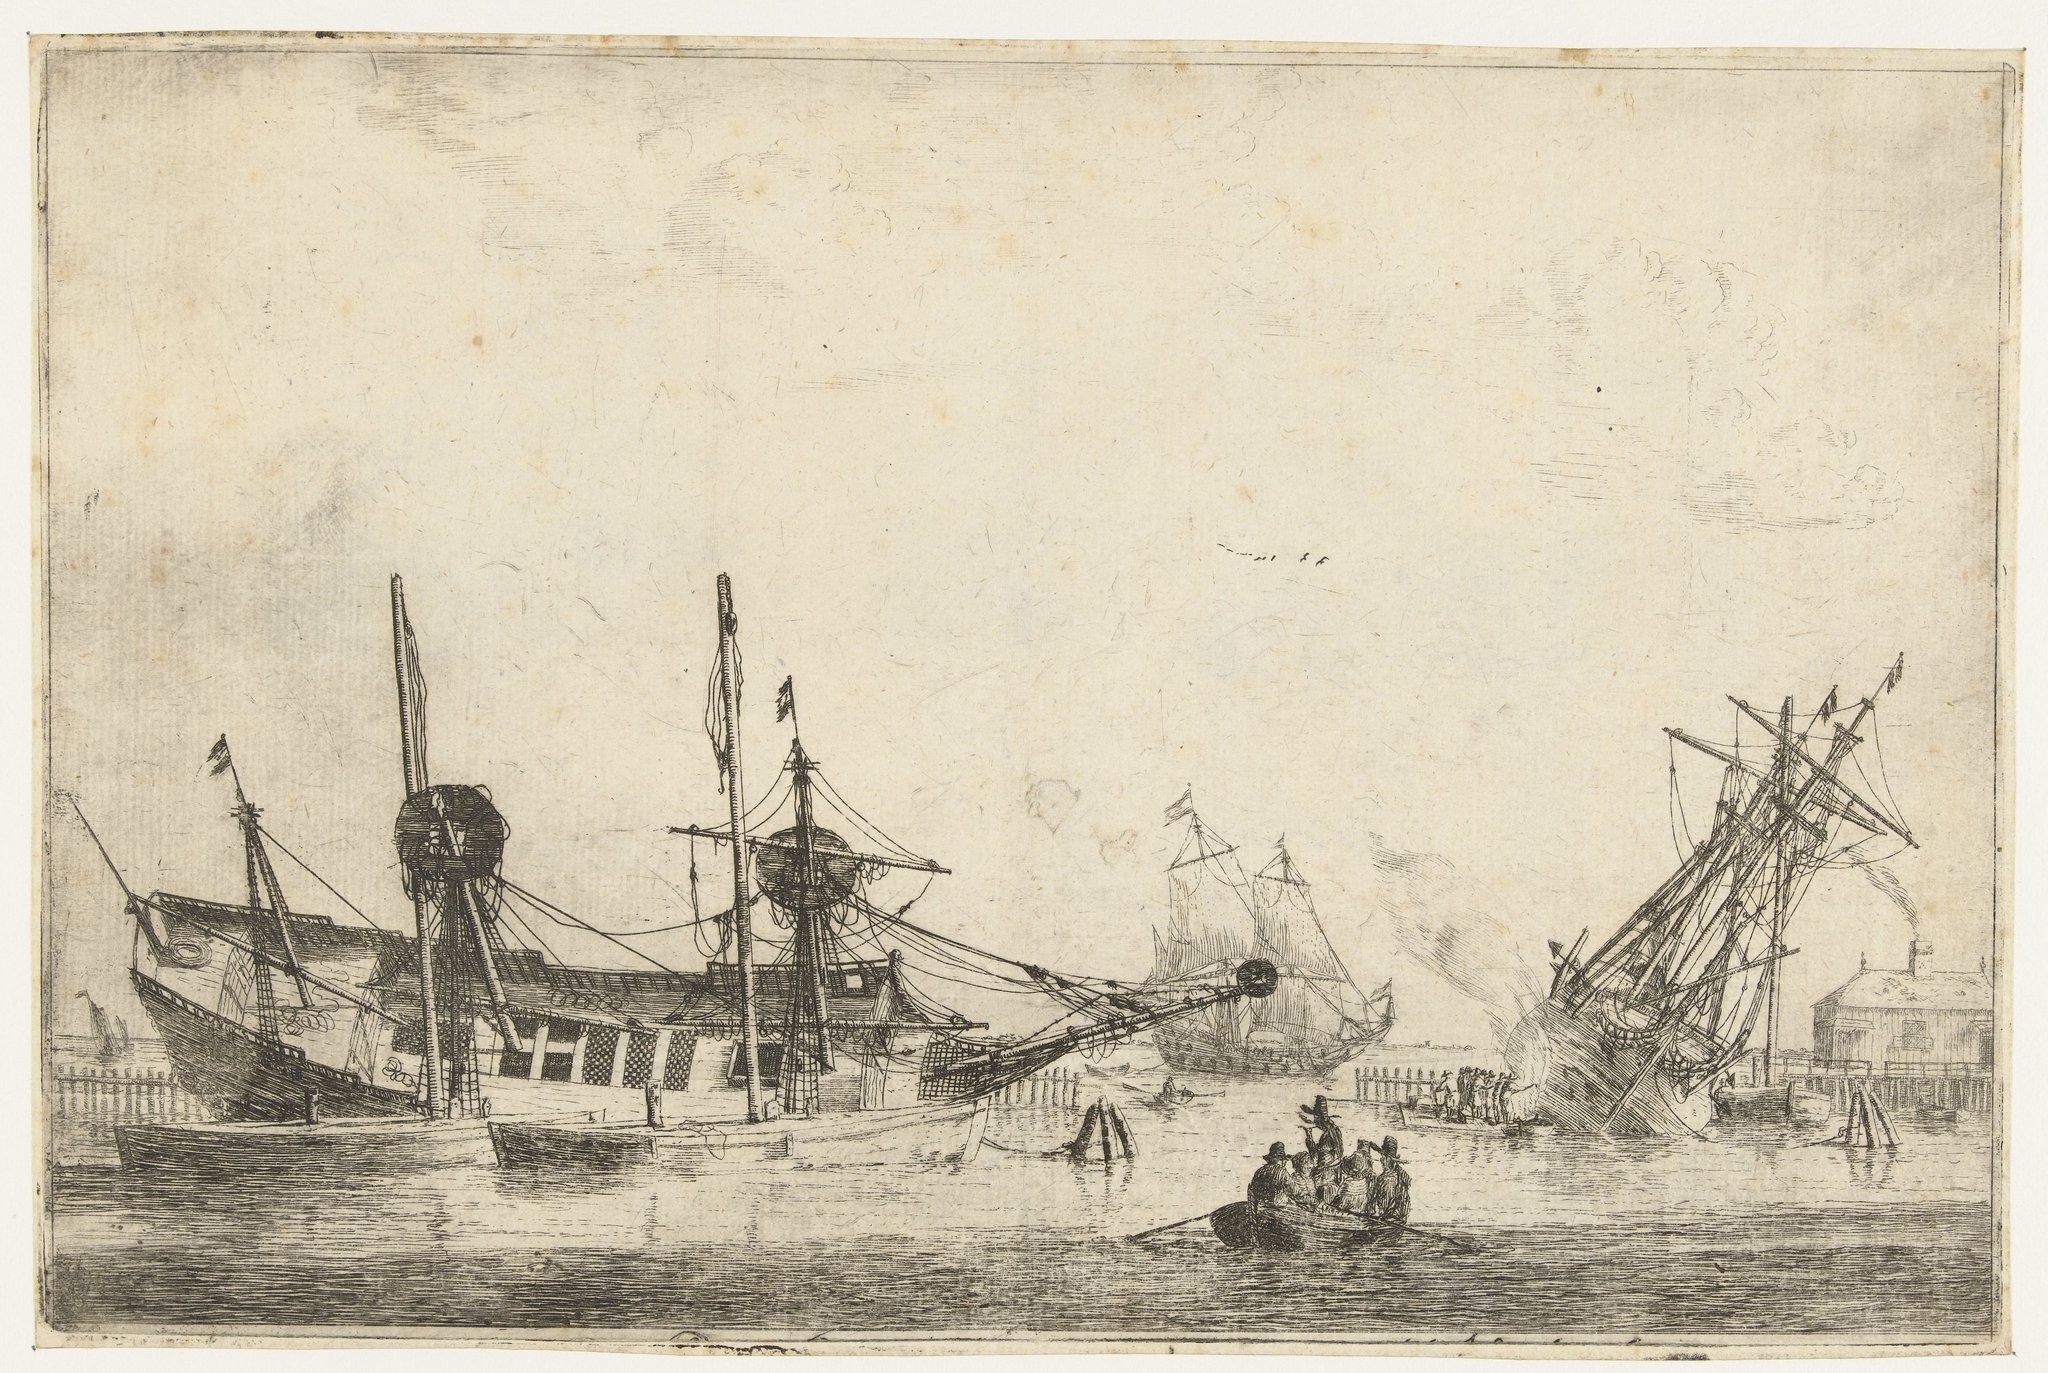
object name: print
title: Dertien scènes met schepen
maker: reinier nooms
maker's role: draughtsman, painter, print maker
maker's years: 1623-1664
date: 1650-1664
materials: paper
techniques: etching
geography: netherlands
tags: repairing, caulking, careening (~ ship)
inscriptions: collector's mark: Lugt 2228a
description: Een werf met twee onderleggers die een groot zeilschip kielen, een gekield schip met mannen die werken aan het waterdichtmaken van de romp en een roeiboot met een aantal mensen erin. Buiten de golfbreker nog een aantal zeilschepen op het water.